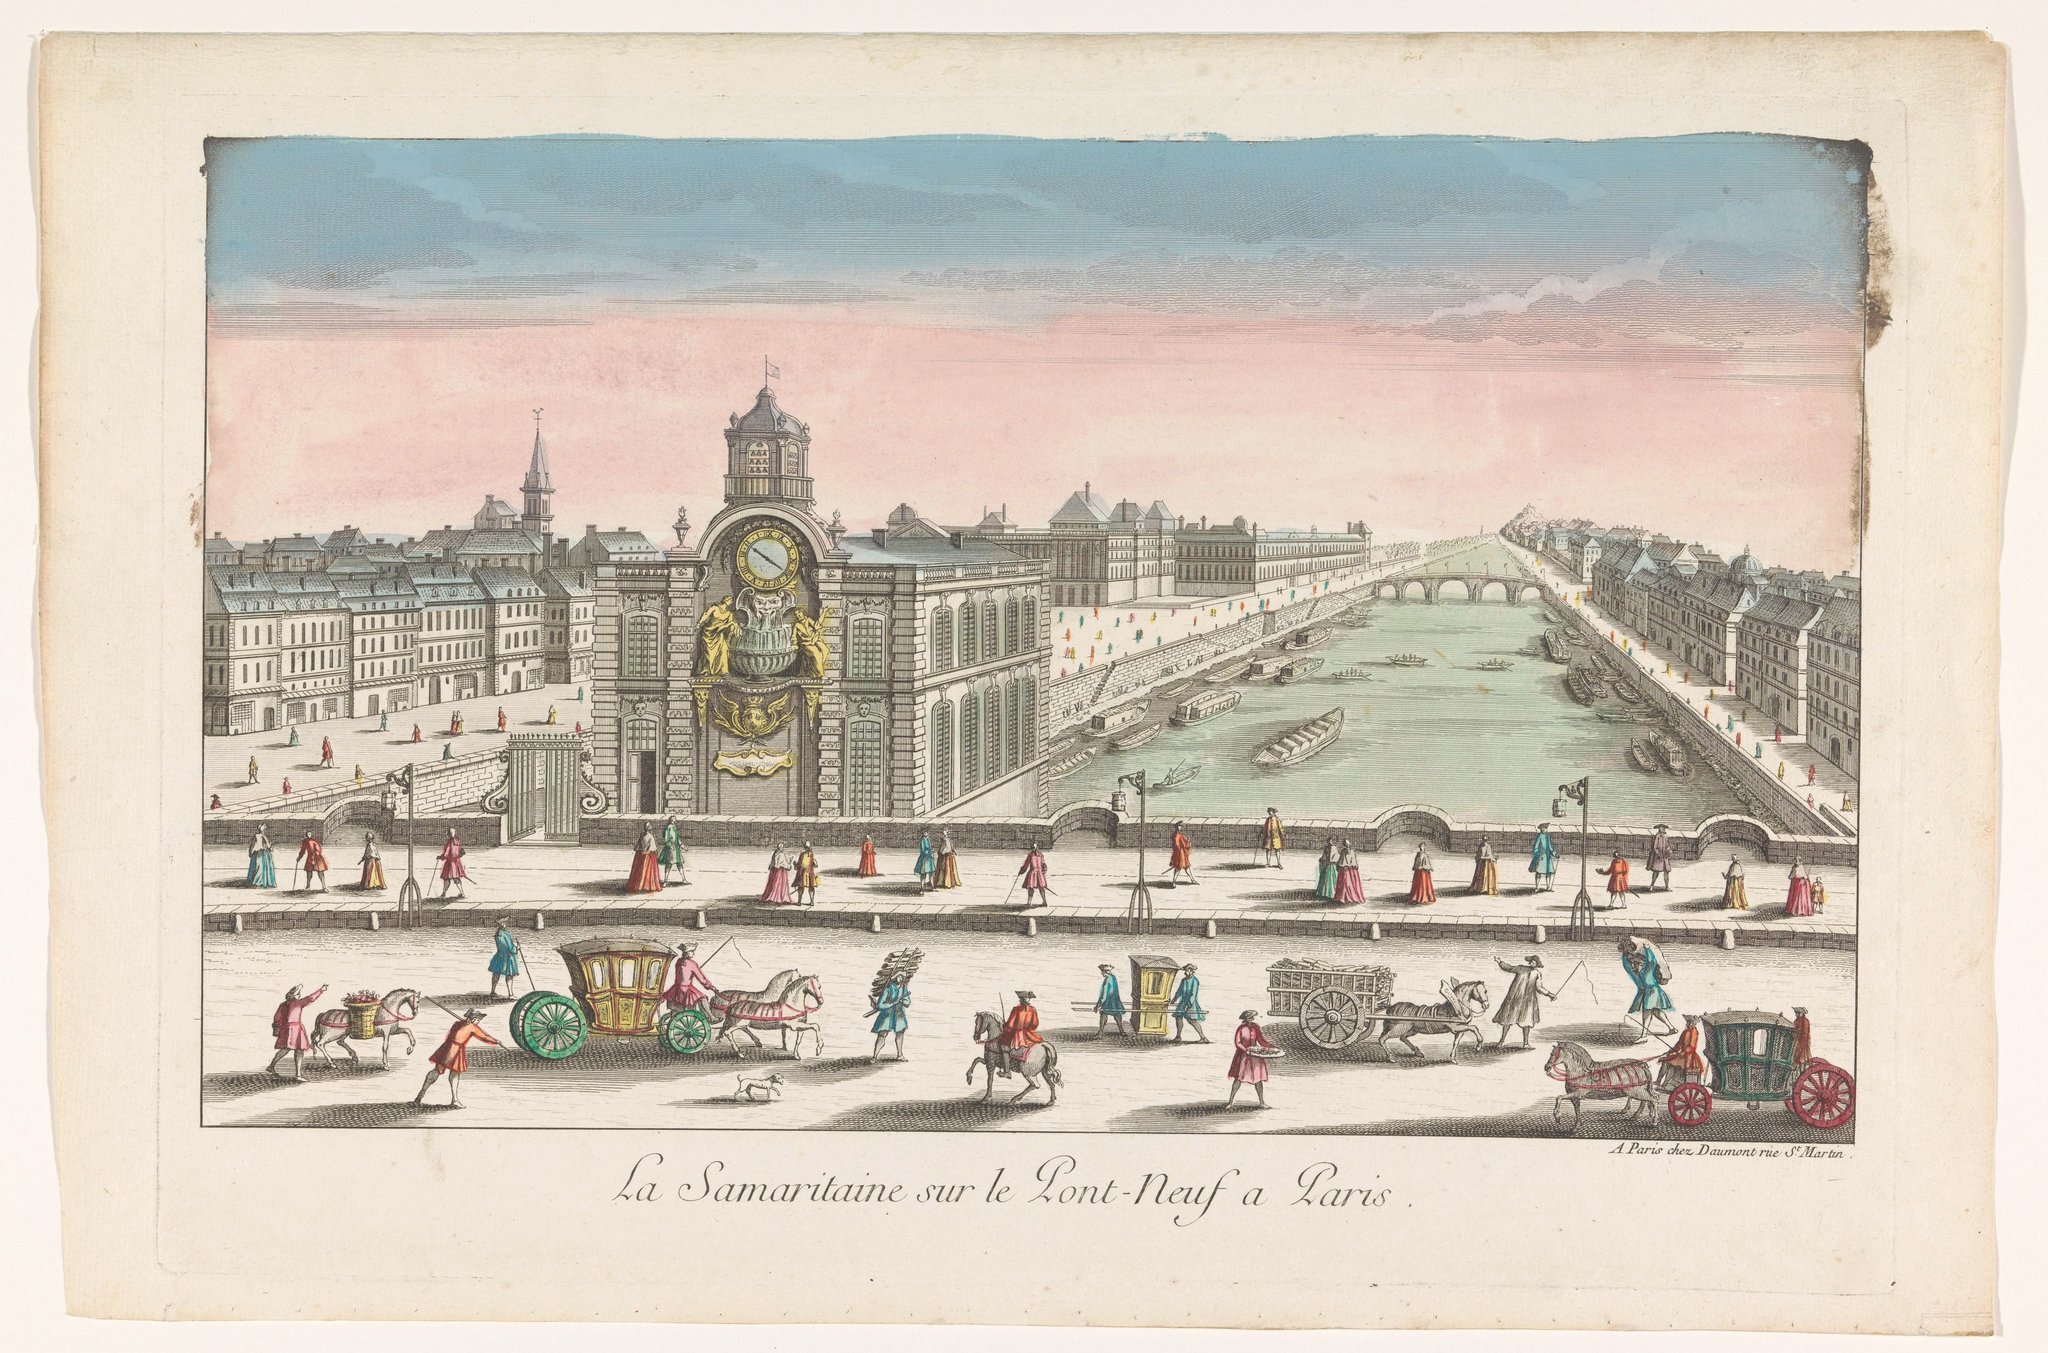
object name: print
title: La Samaritaine sur le Pont-Neuf a Paris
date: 1745-1775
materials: paper, watercolor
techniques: brush, etching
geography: france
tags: bridge in city across river, canal, etc. (+ city(-scape) with figures, staffage), christ and the woman of samaria: sitting at jacob's well he asks her for a drink from her jug, pump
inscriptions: collector's mark: Lugt 2166, watermark